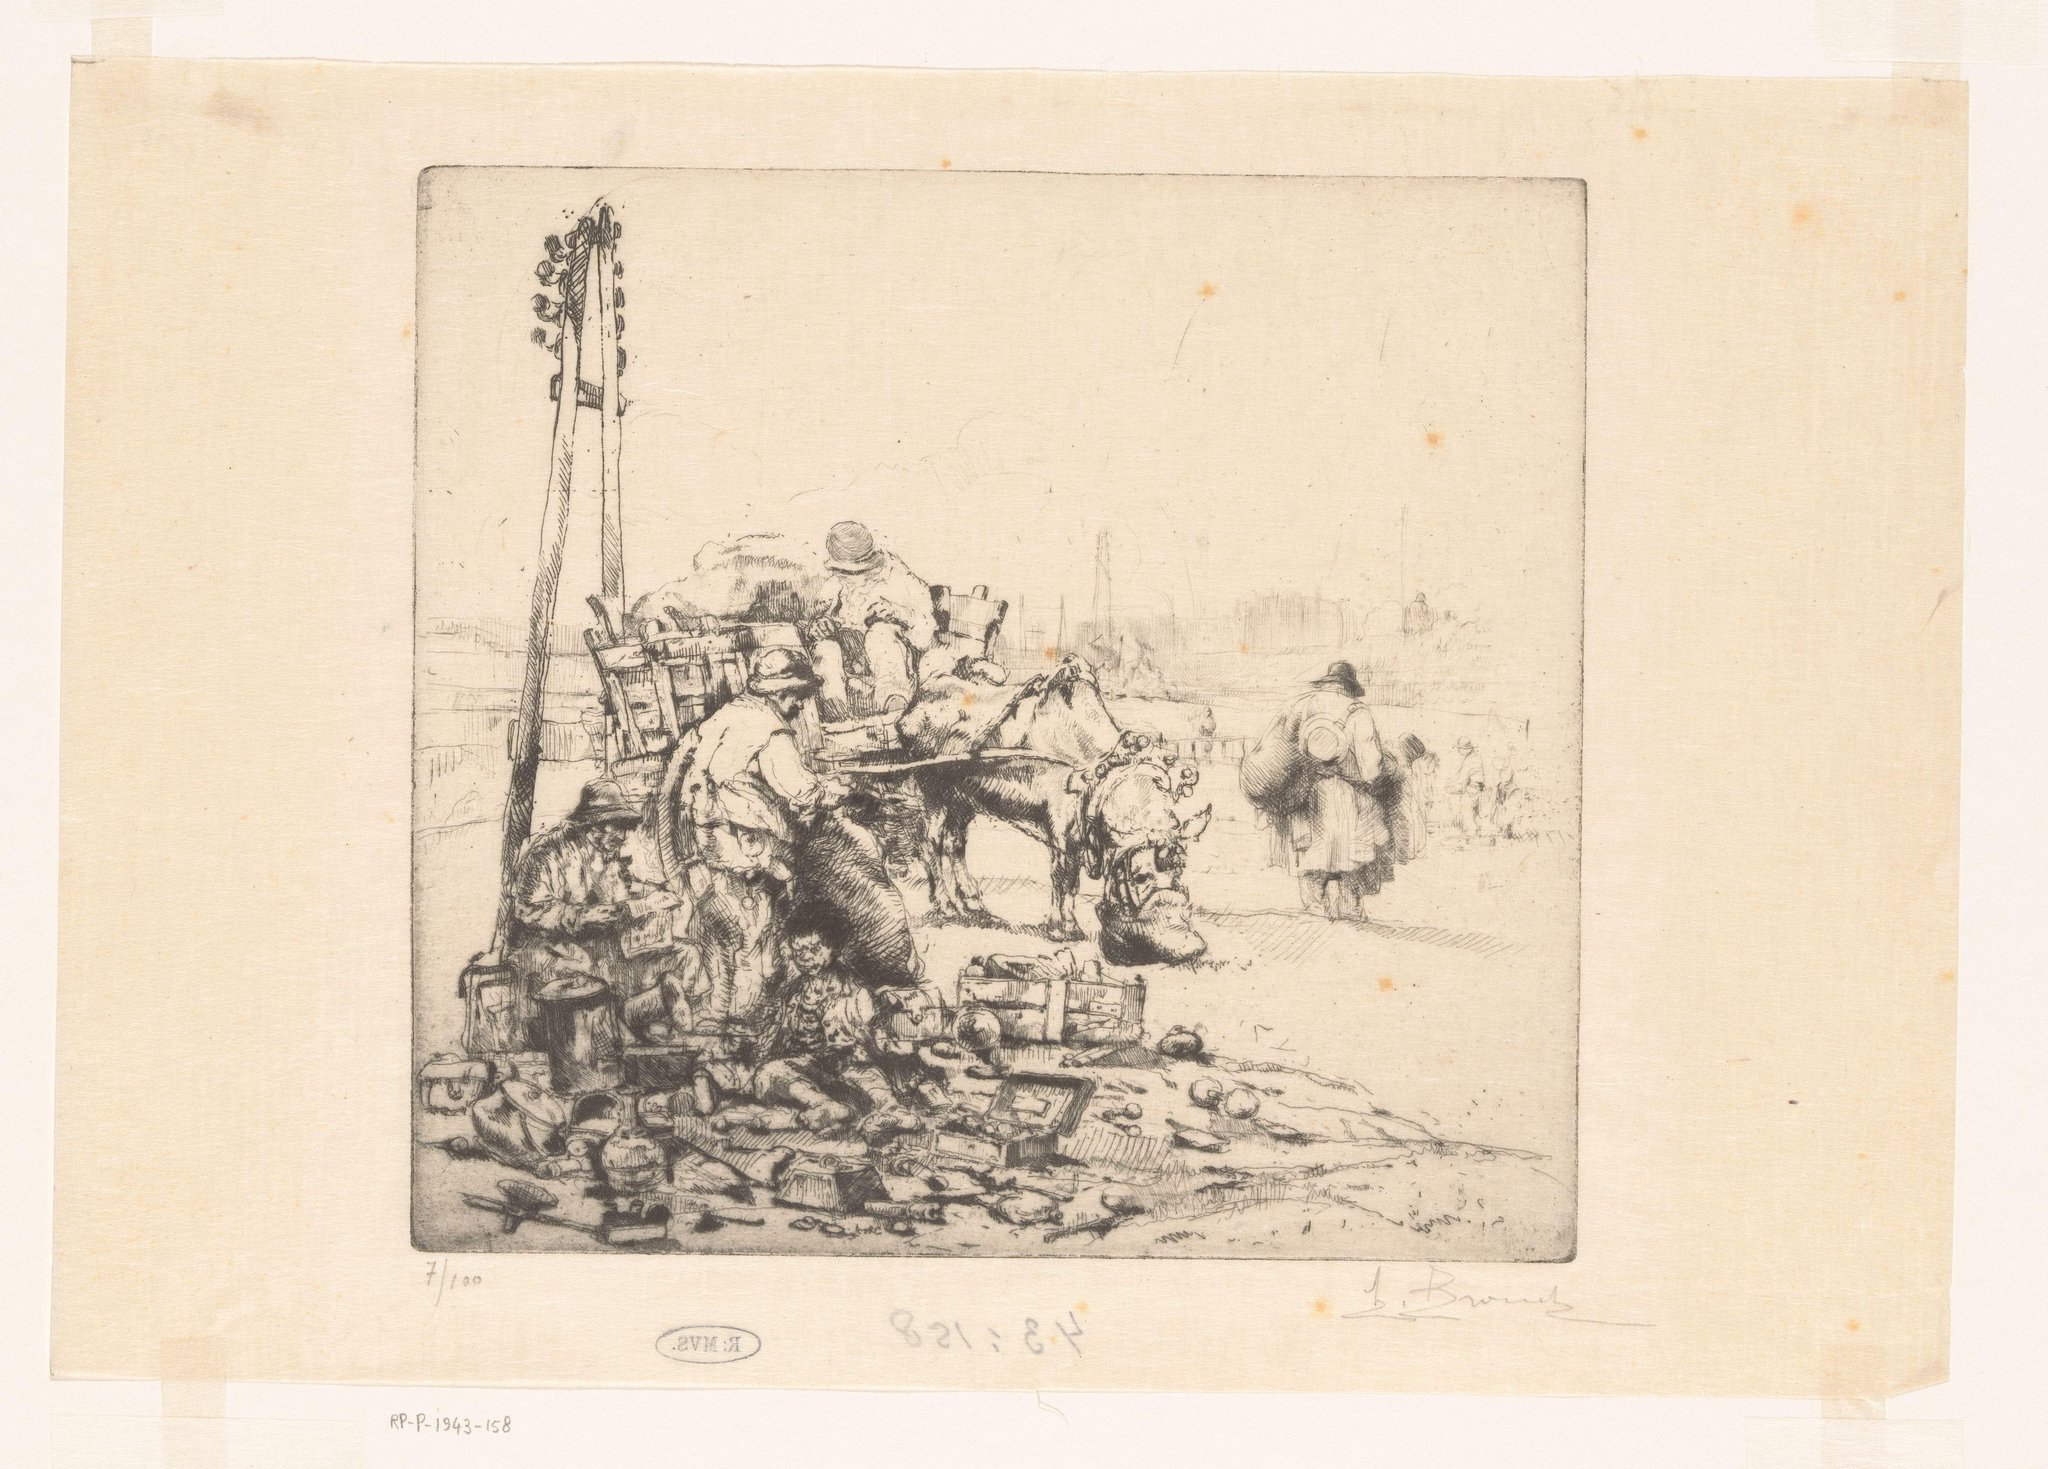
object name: print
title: Vlooienmarkt in een landschap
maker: auguste brouet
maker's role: painter, print maker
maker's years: 1872-1941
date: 1882-1941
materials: paper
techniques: drypoint, etching, intaglio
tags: landscapes, market, merchant, salesman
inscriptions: collector's mark: Lugt 2228